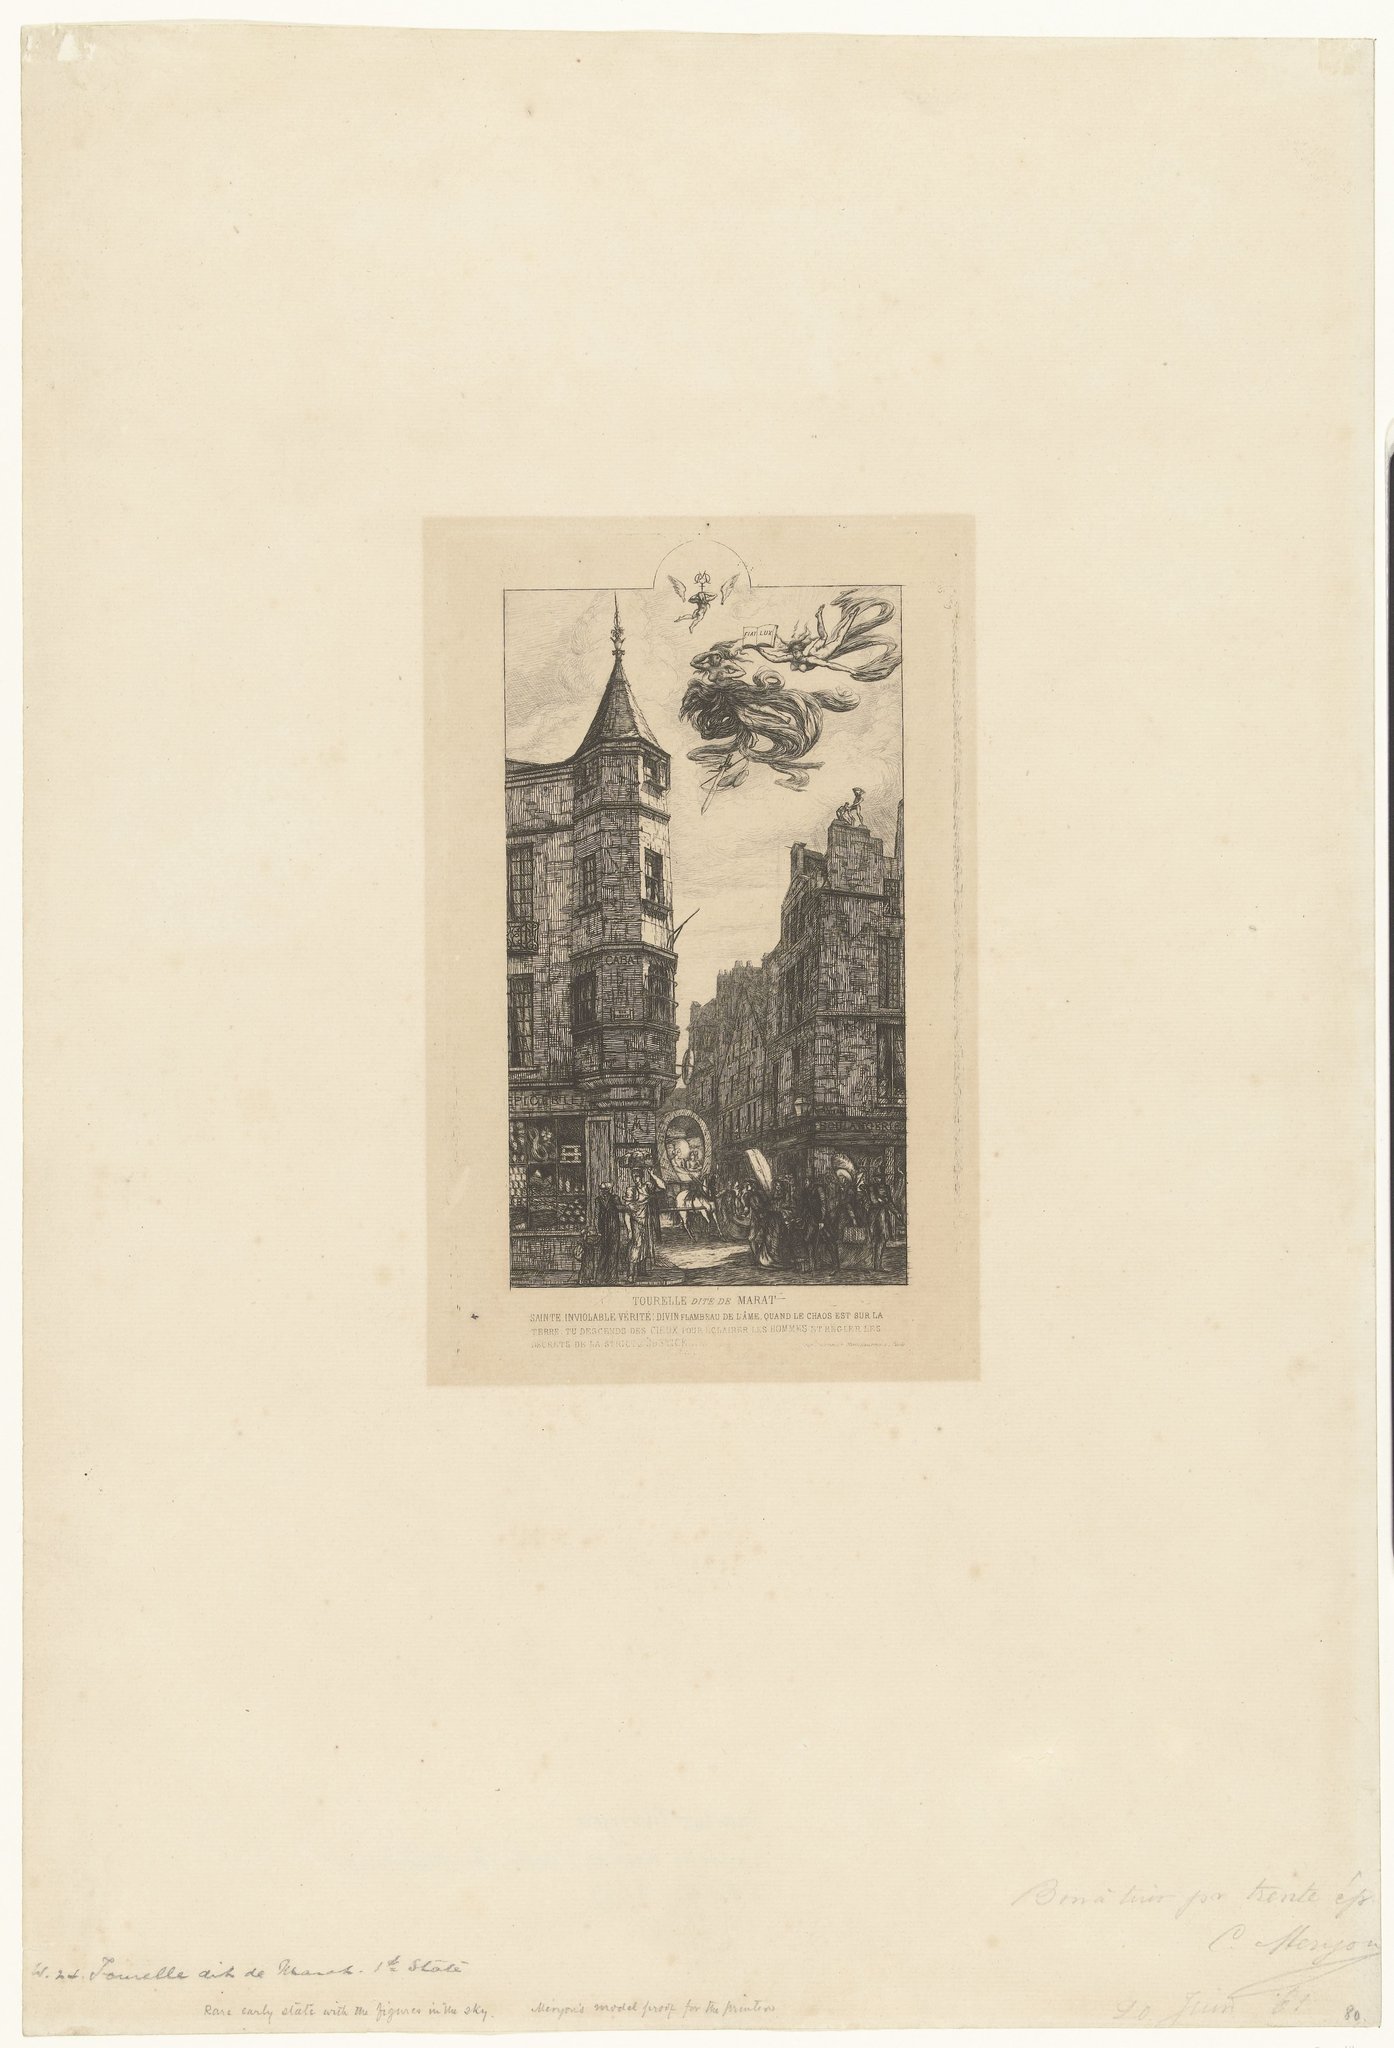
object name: print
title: Tourelle dite de Marat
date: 1861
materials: paper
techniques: drypoint, etching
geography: paris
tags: street, marketing, shopping (~ household management), paris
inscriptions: collector's mark, inscription: ‘Bon à tirer pr trente ép/ C.Meryon/ 20 Juin '61’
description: Torentje op hoek van winkelpand in de Rue de l'Ecole-de-Médicine in Parijs. In dit huis werd Jean-Paul Marat vermoord door Charlotte Corday. Het is druk in de winkelstraat met mannen en vrouwen die boodschappen doen en een rijtuig dat wordt getrokken door een paard. Op het dak van het gebouw rechts staan twee dakwerkers, zij kijken naar figuren in de lucht, personificaties van de Waarheid, Gerechtigheid en de Onschuld. Frans onderschrift in drie regels: Sainte inviolable vérité ... la stricte justice.